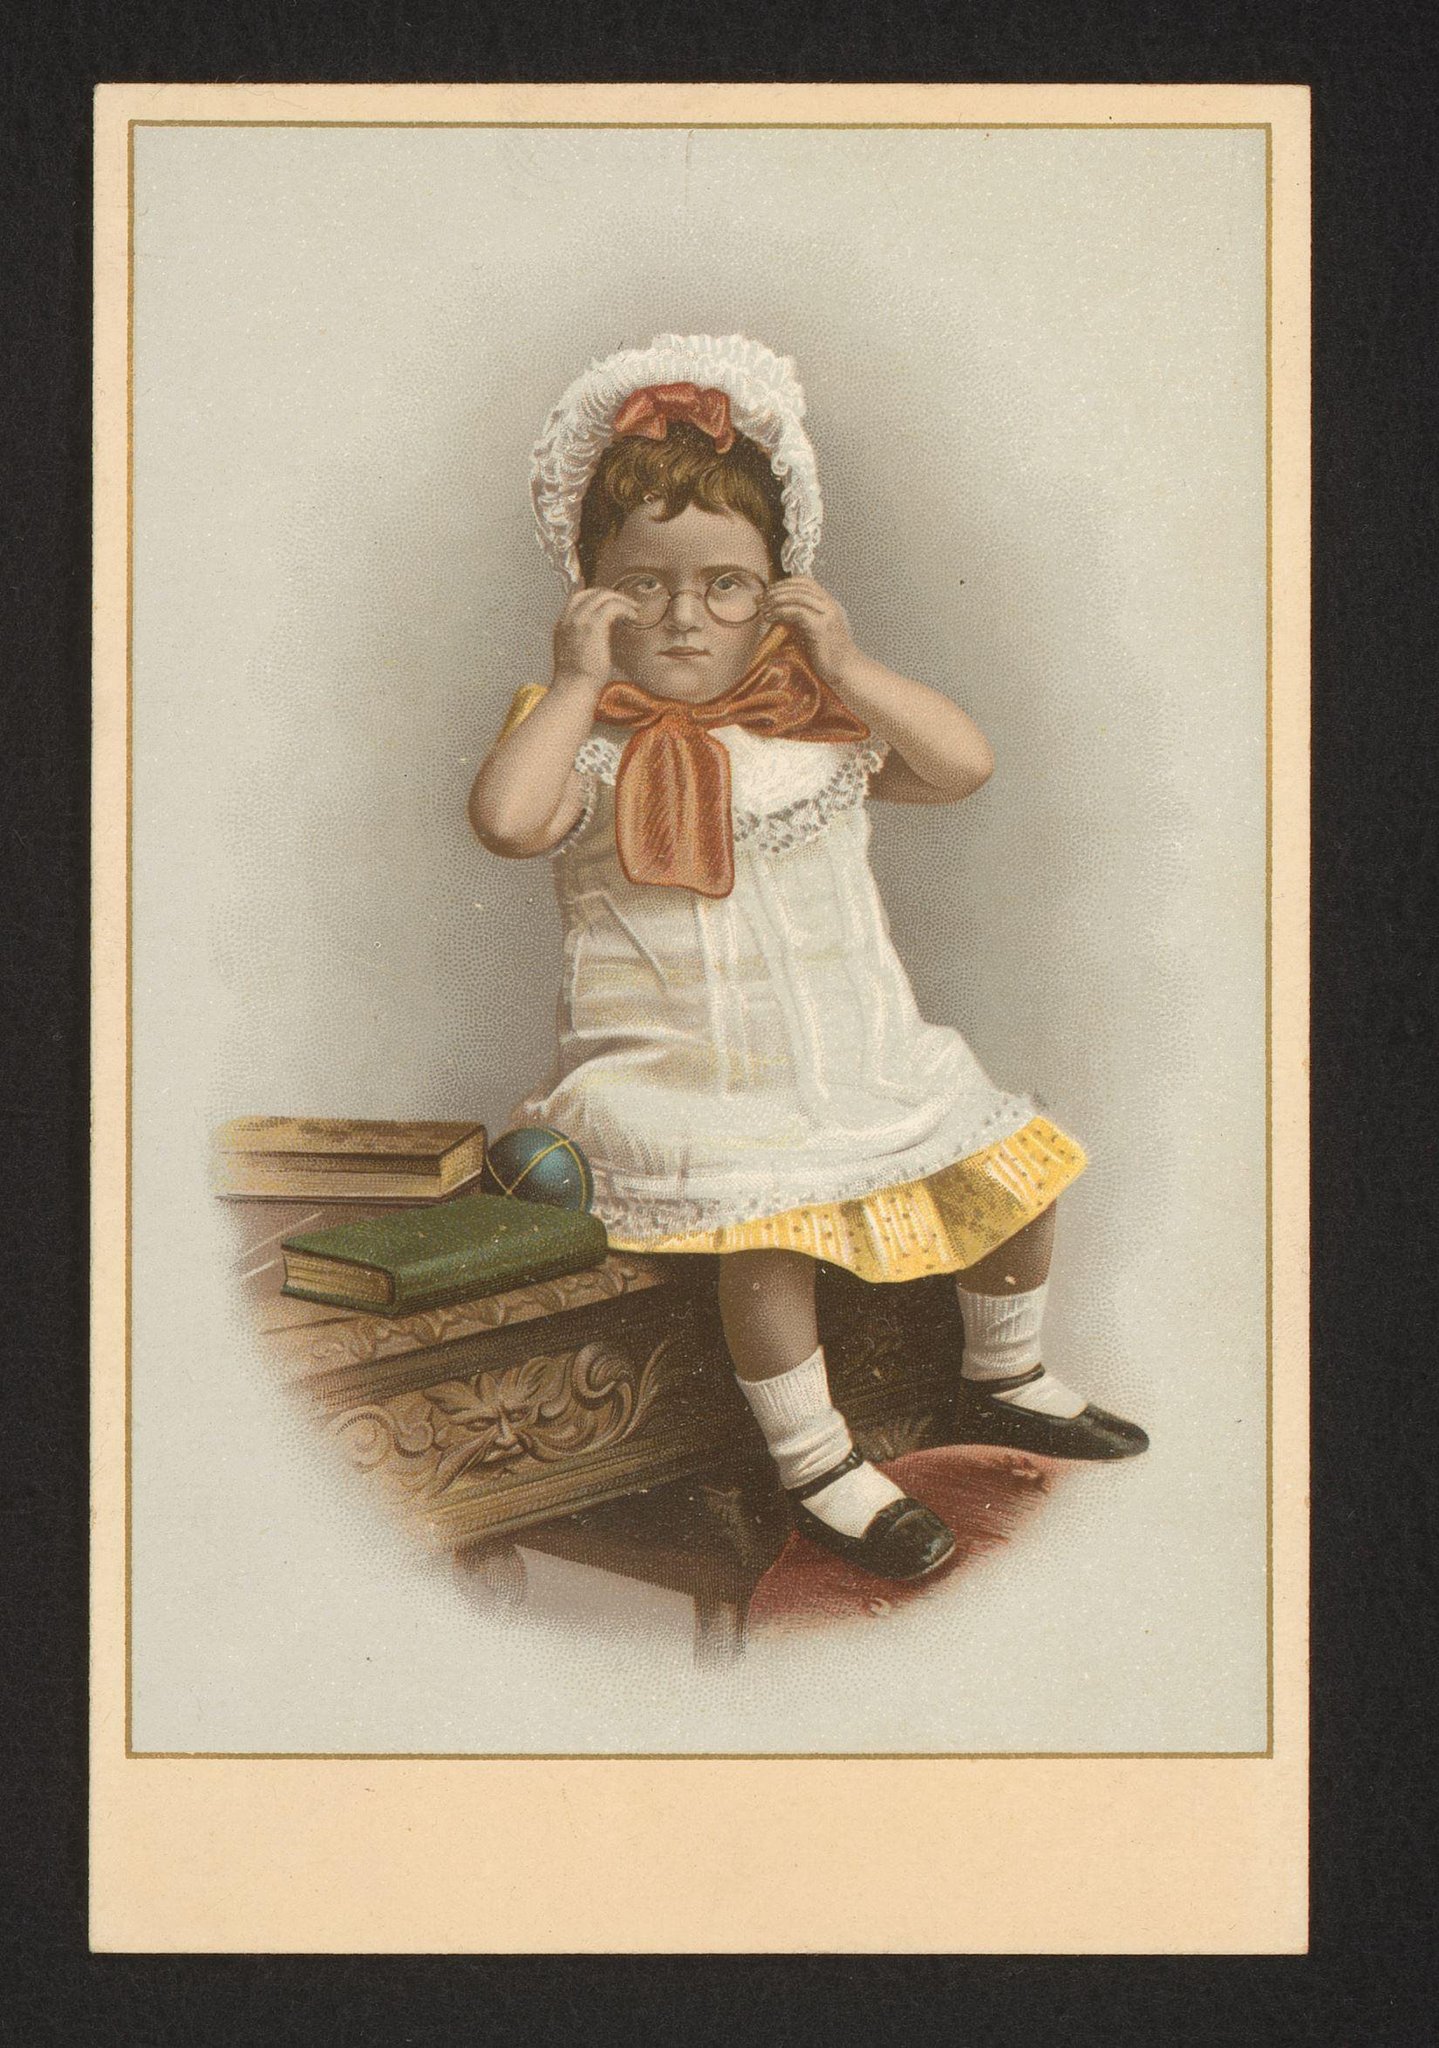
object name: print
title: Portret van een zittend meisje met bril en witte muts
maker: Anonymous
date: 1880-1920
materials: cardboard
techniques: chromolithography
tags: eyeglasses, spectacles, sitting figure - aa - female human figure, historical persons - bb - woman, head-gear: cap, toddler (female)